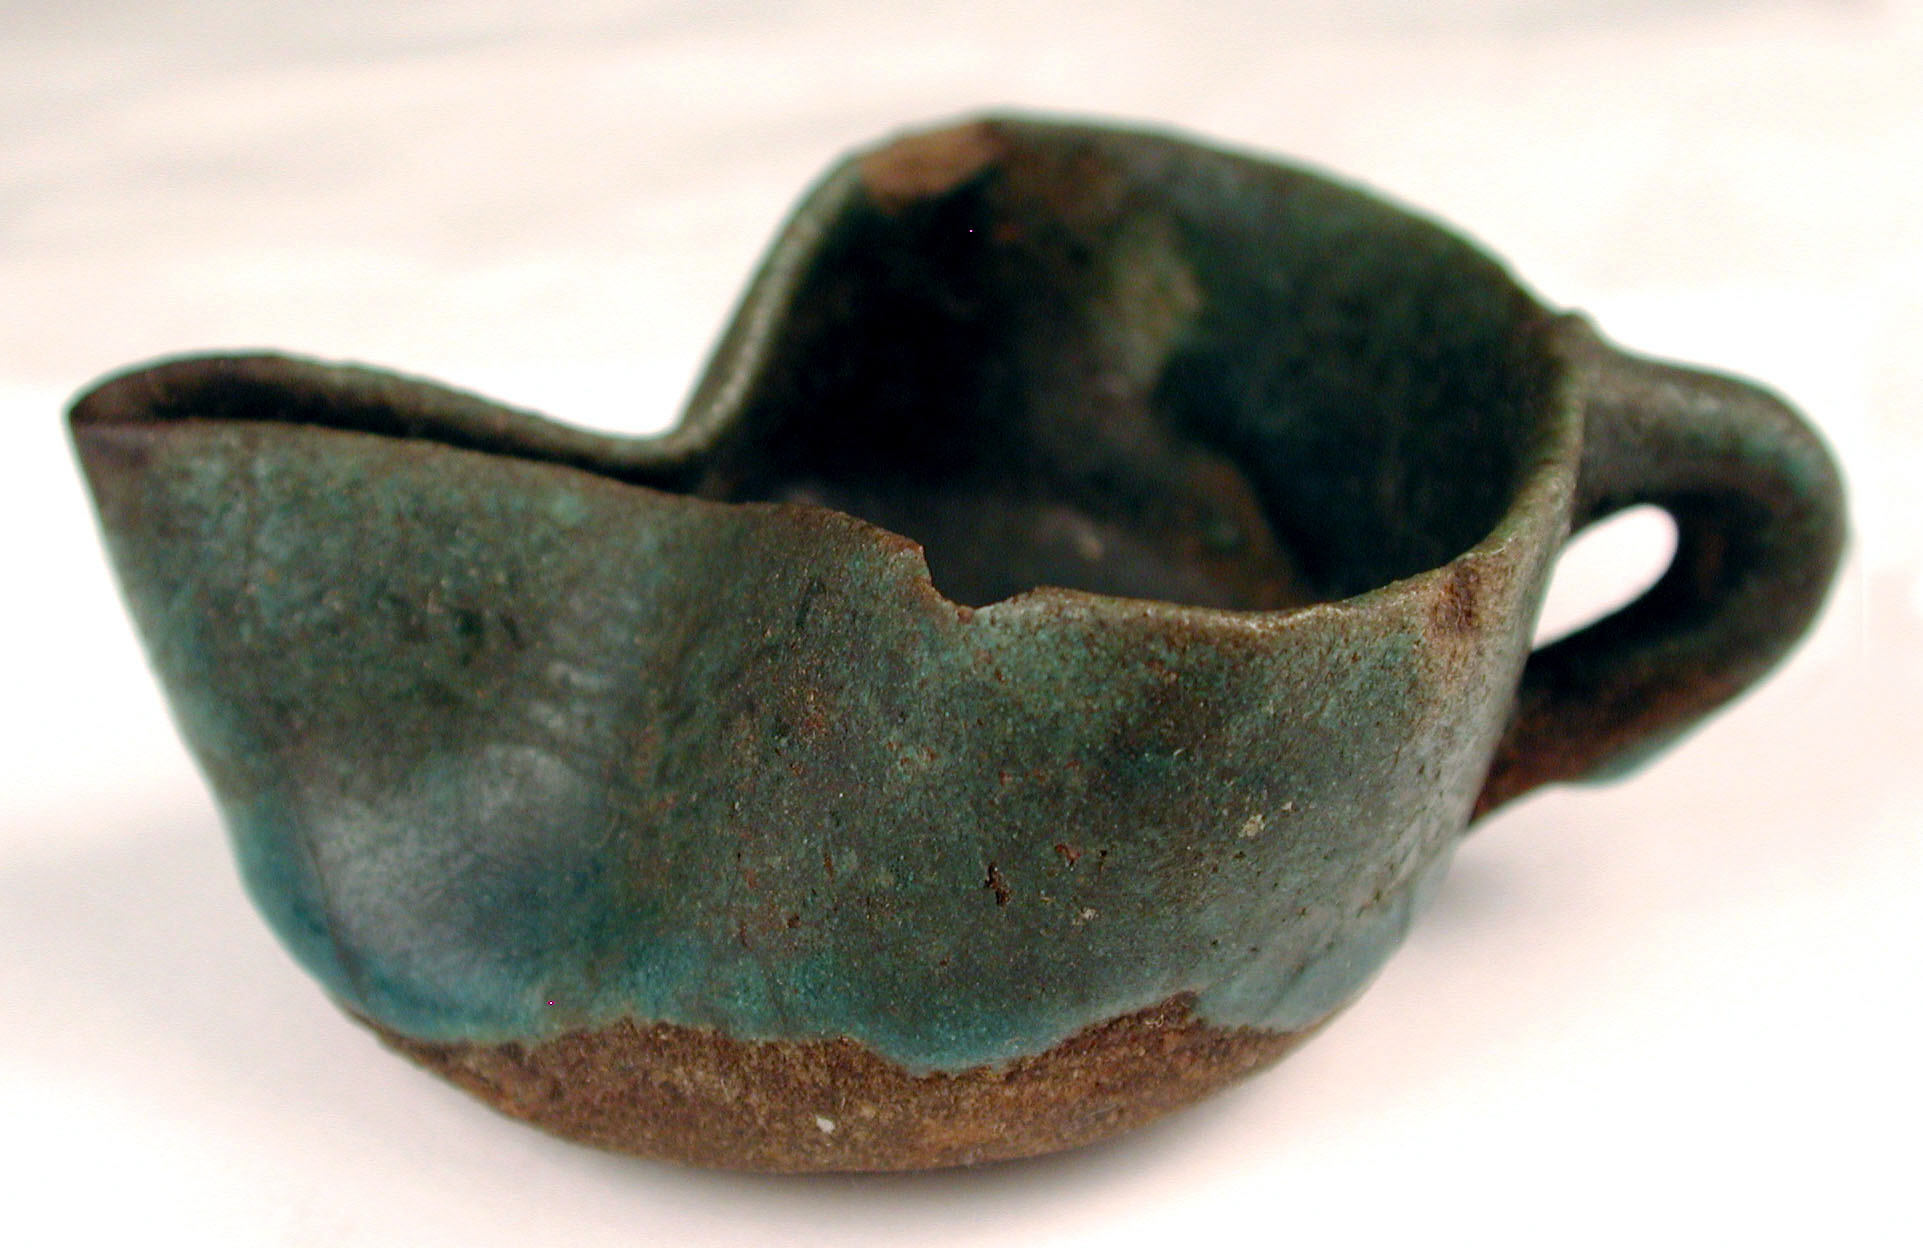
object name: lamp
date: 901-1100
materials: stonepaste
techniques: glazing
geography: iran